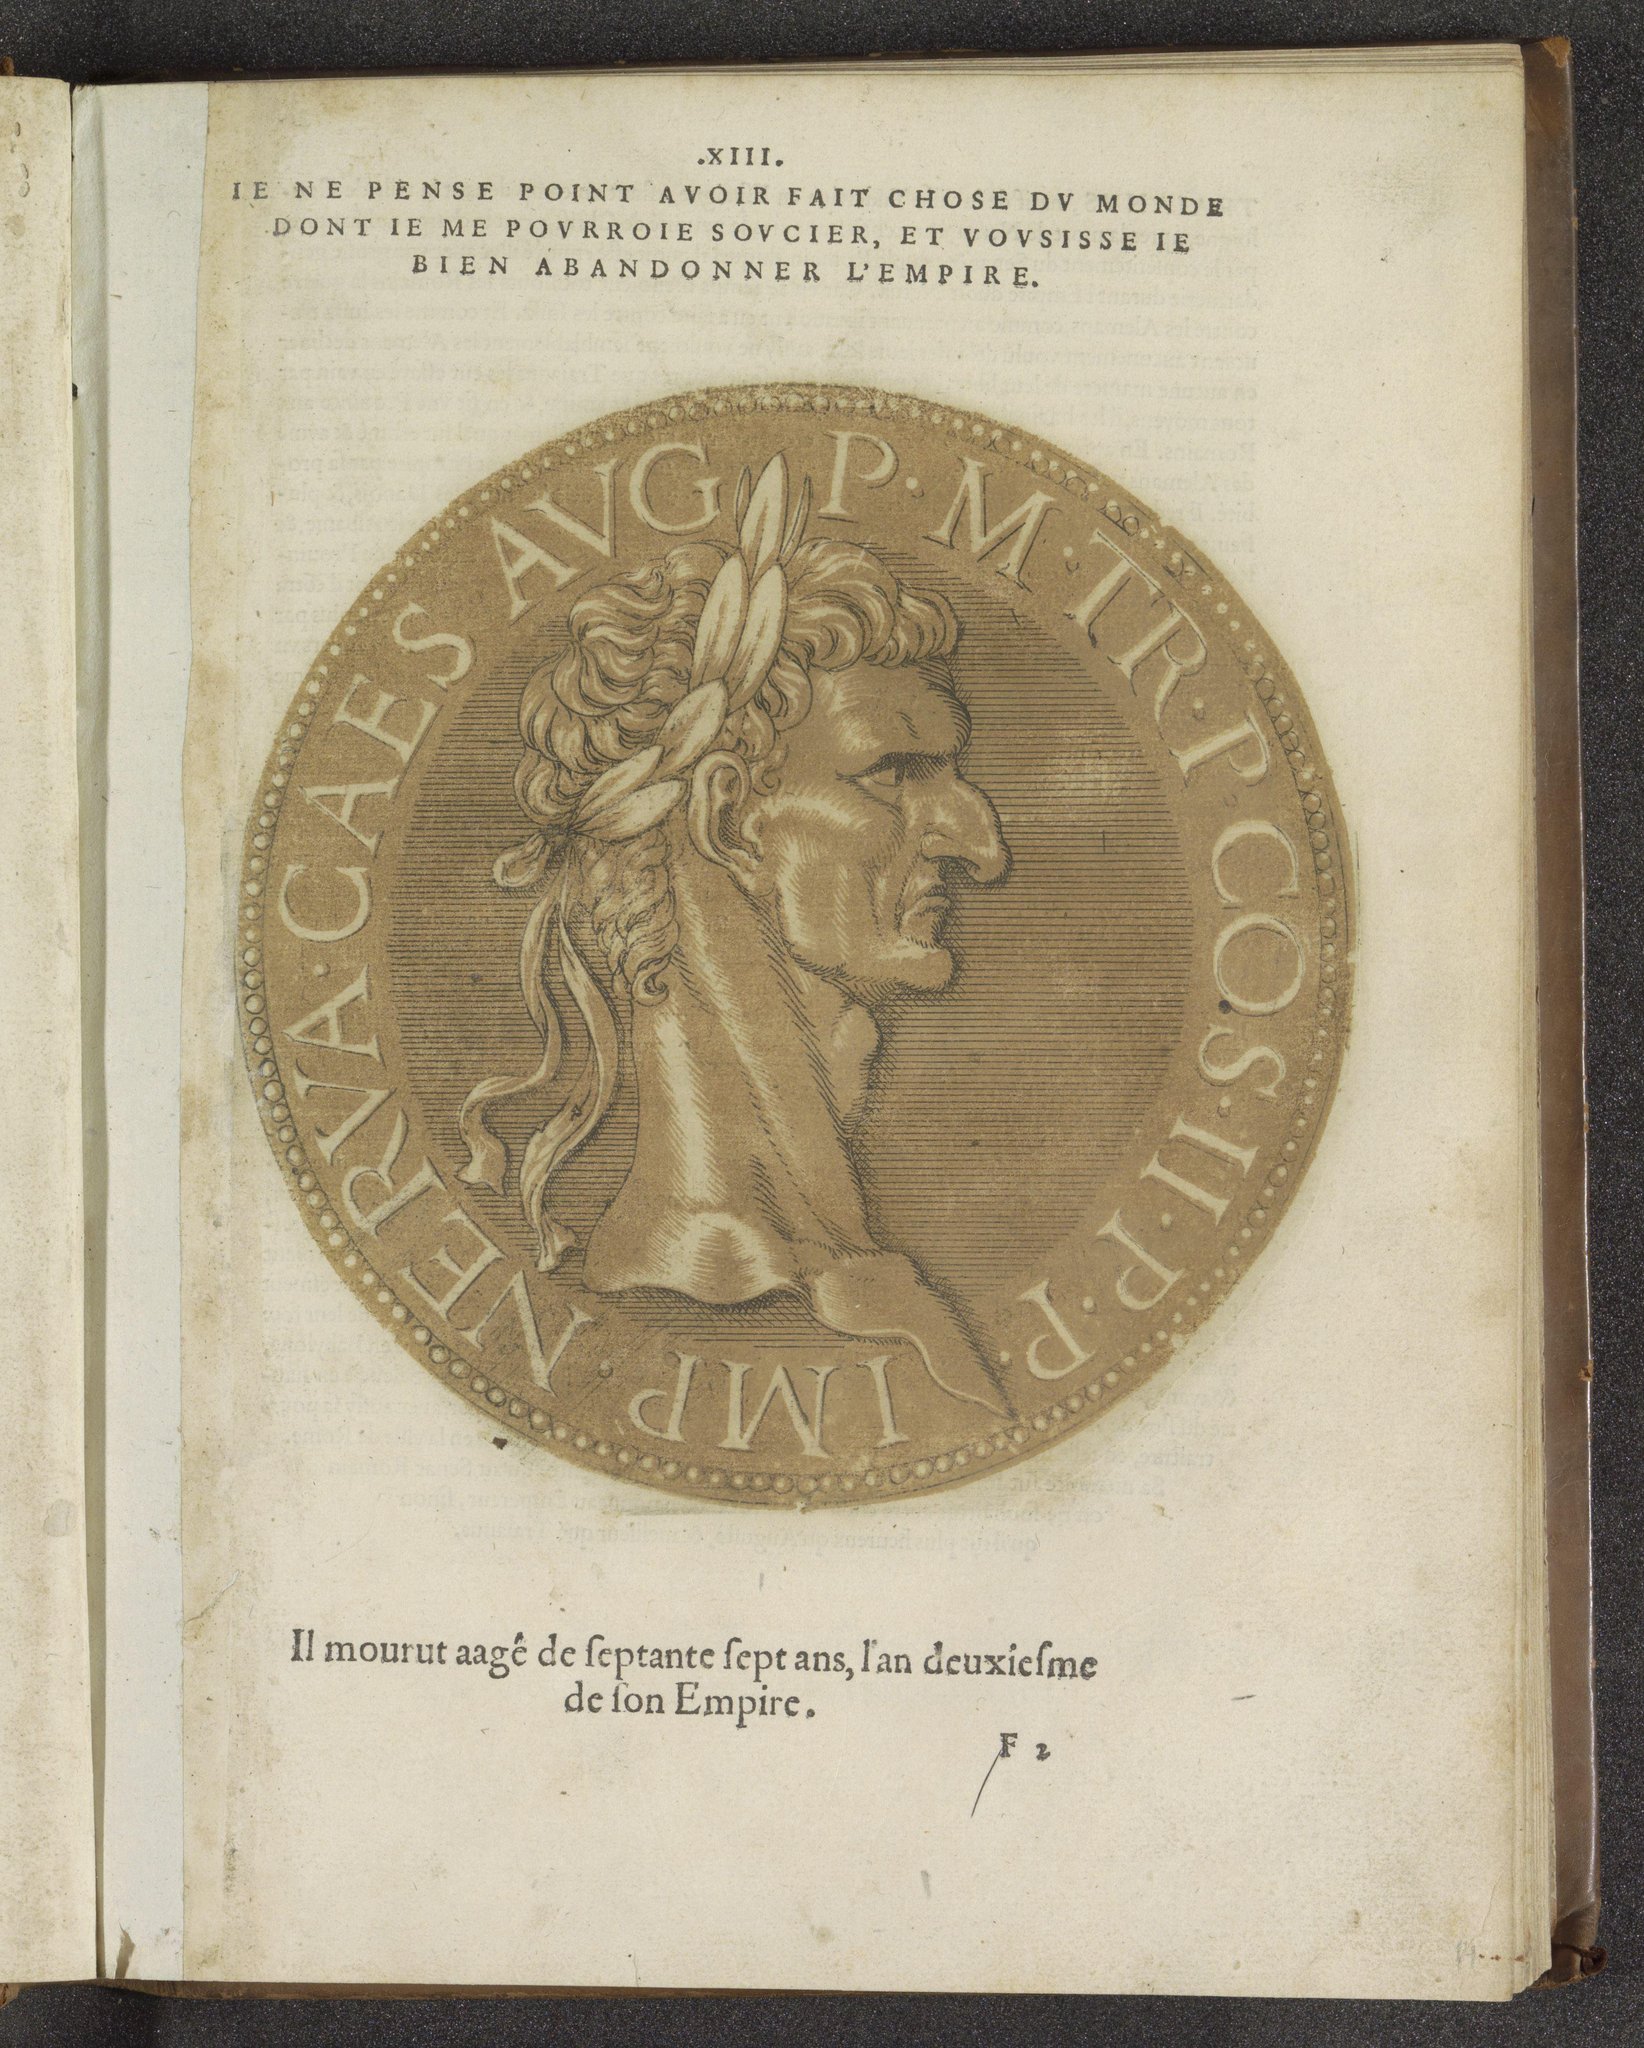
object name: page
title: Portret van keizer Nerva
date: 1557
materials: paper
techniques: woodcut, etching, letterpress printing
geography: antwerp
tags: rome, emperor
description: Portret van keizer Nerva, op een munt met randschrift. De prent maakt deel uit van een boek over de keizers vanaf Julius Caesar tot en met Karel V en zijn broer Ferdinand.